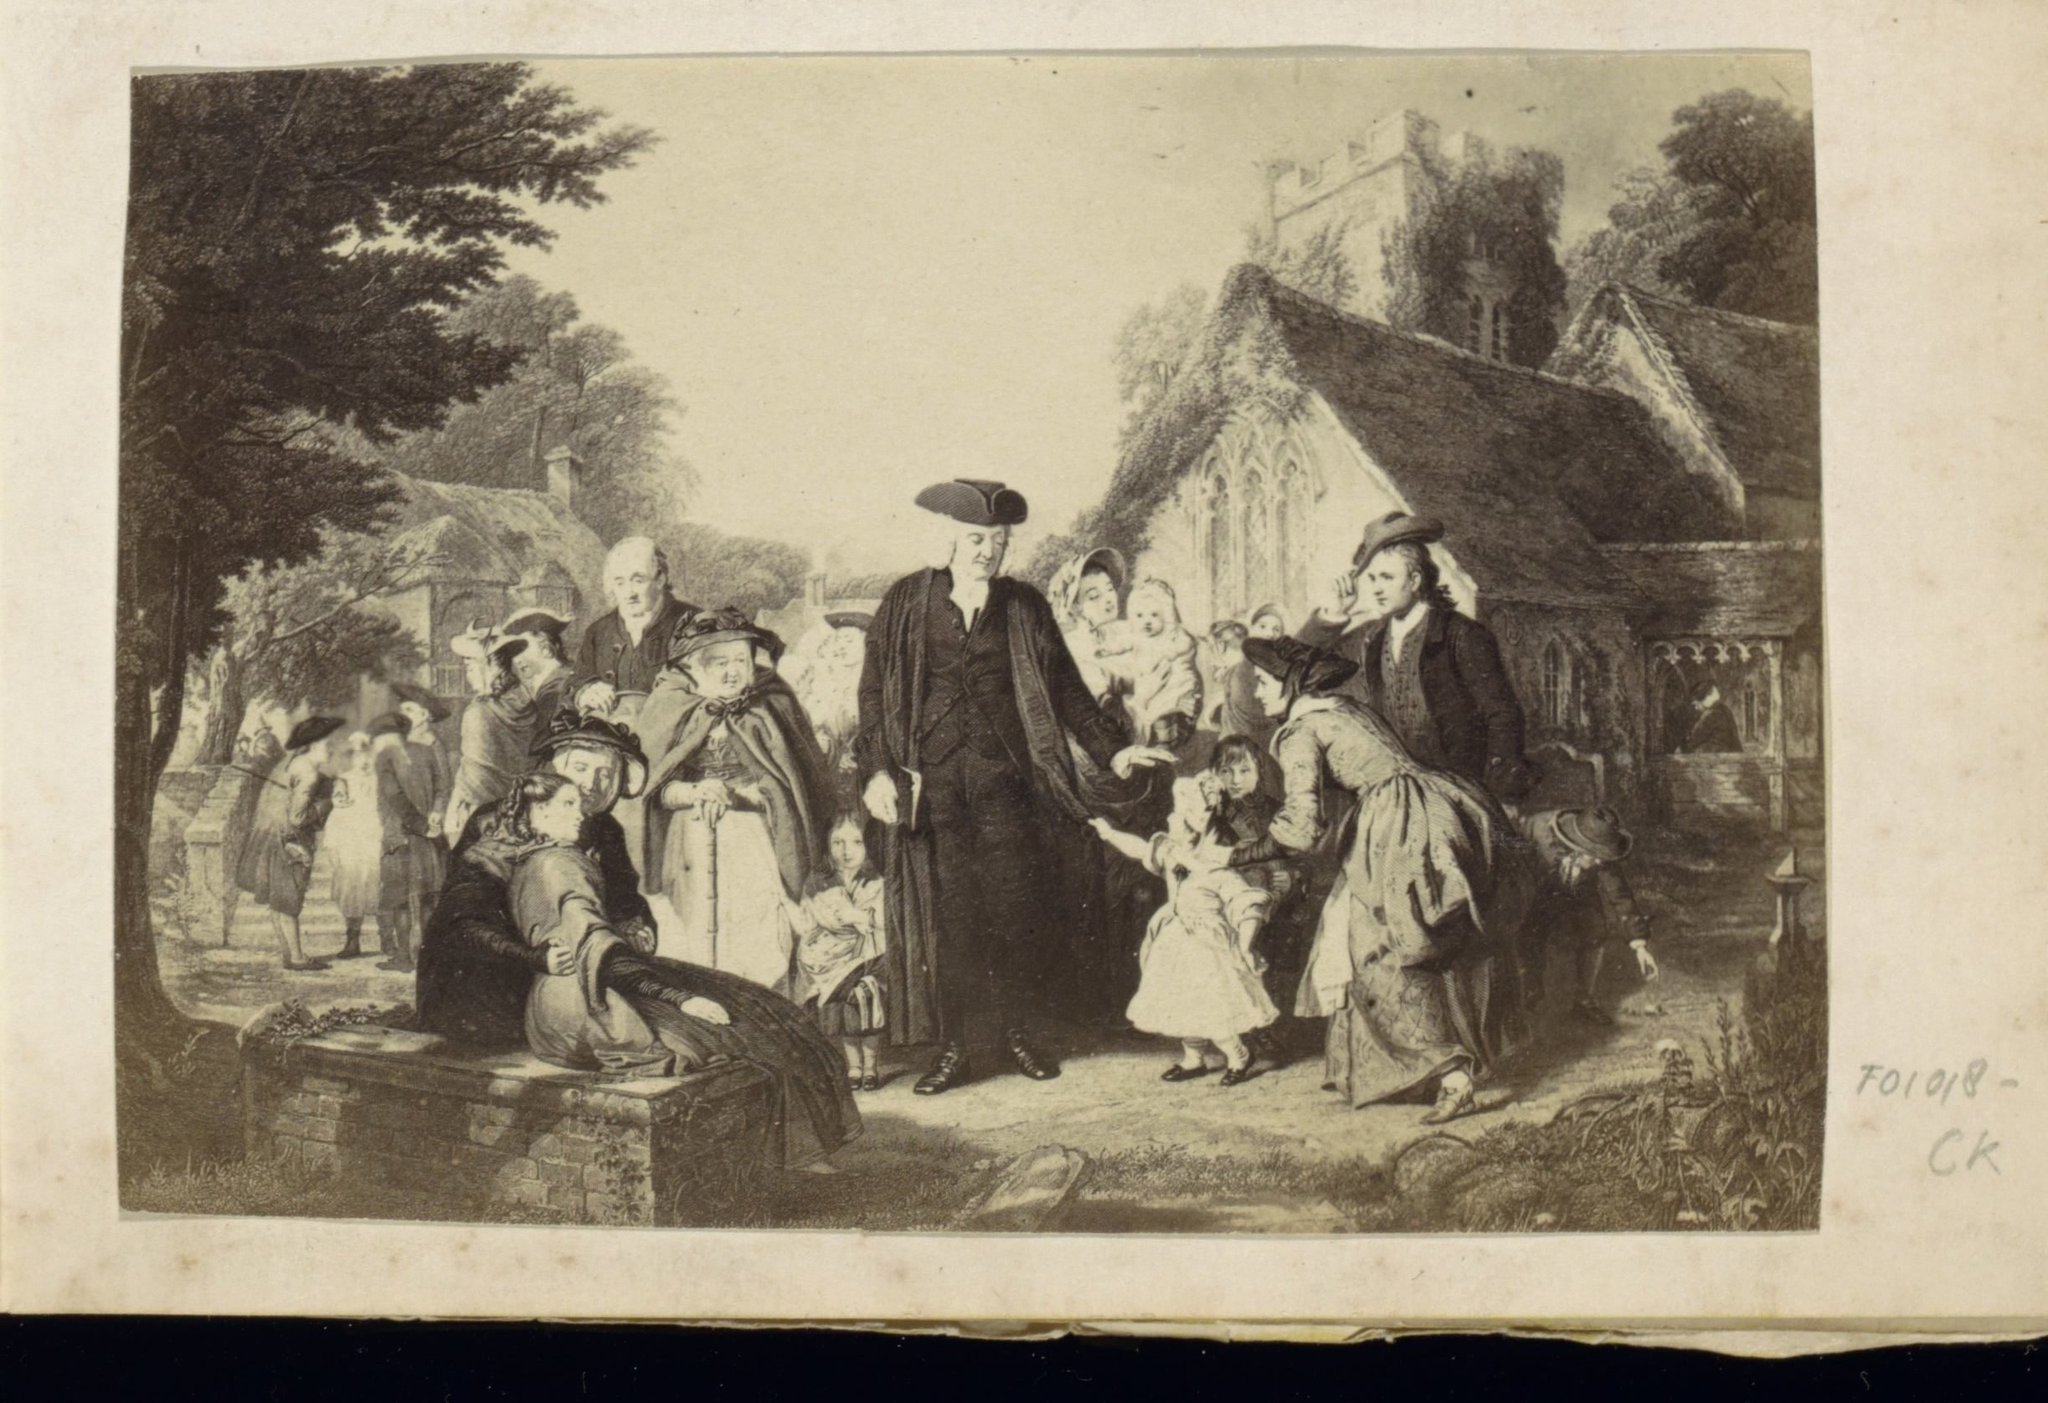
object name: photograph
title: Fotoreproductie van een prent van een begroetingstafereel bij een kerkje op het platteland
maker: Anonymous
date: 1860-1870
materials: paper, photographic support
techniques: albumen print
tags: baring the head, lifting one's hat, grandparent(s) with grandchild(ren) (family group), saluting, church (exterior) - qq - small church, chapel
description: Onderdeel van Engels familiealbum met foto's van personen, reizen, cricket en kunstwerken.